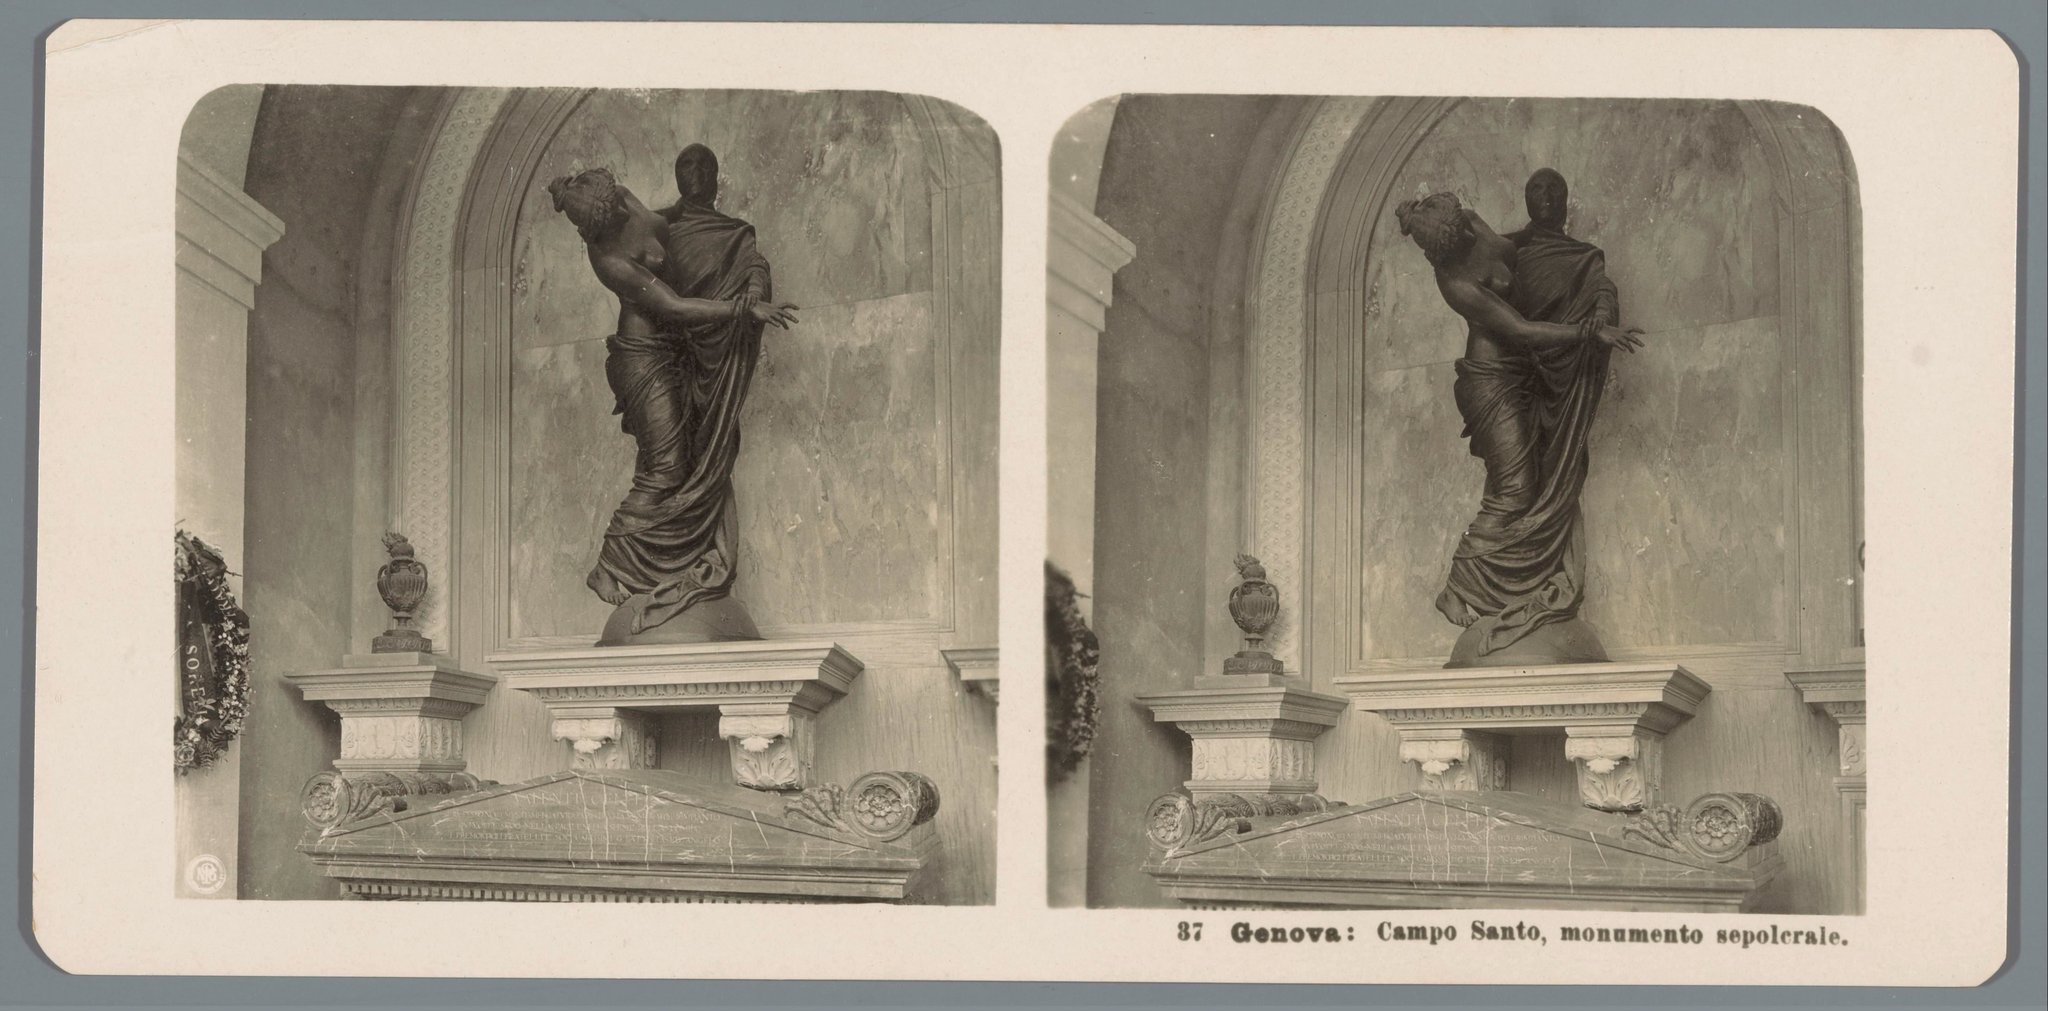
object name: stereograph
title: Grafmonument in de begraafplaats van Staglieno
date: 1900-1910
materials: cardboard, photographic support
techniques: gelatin silver print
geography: genoa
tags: sculpture, churchyard, cemetery, grave-building, monumental tomb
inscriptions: inscription: ‘NPG’, number: ‘37’